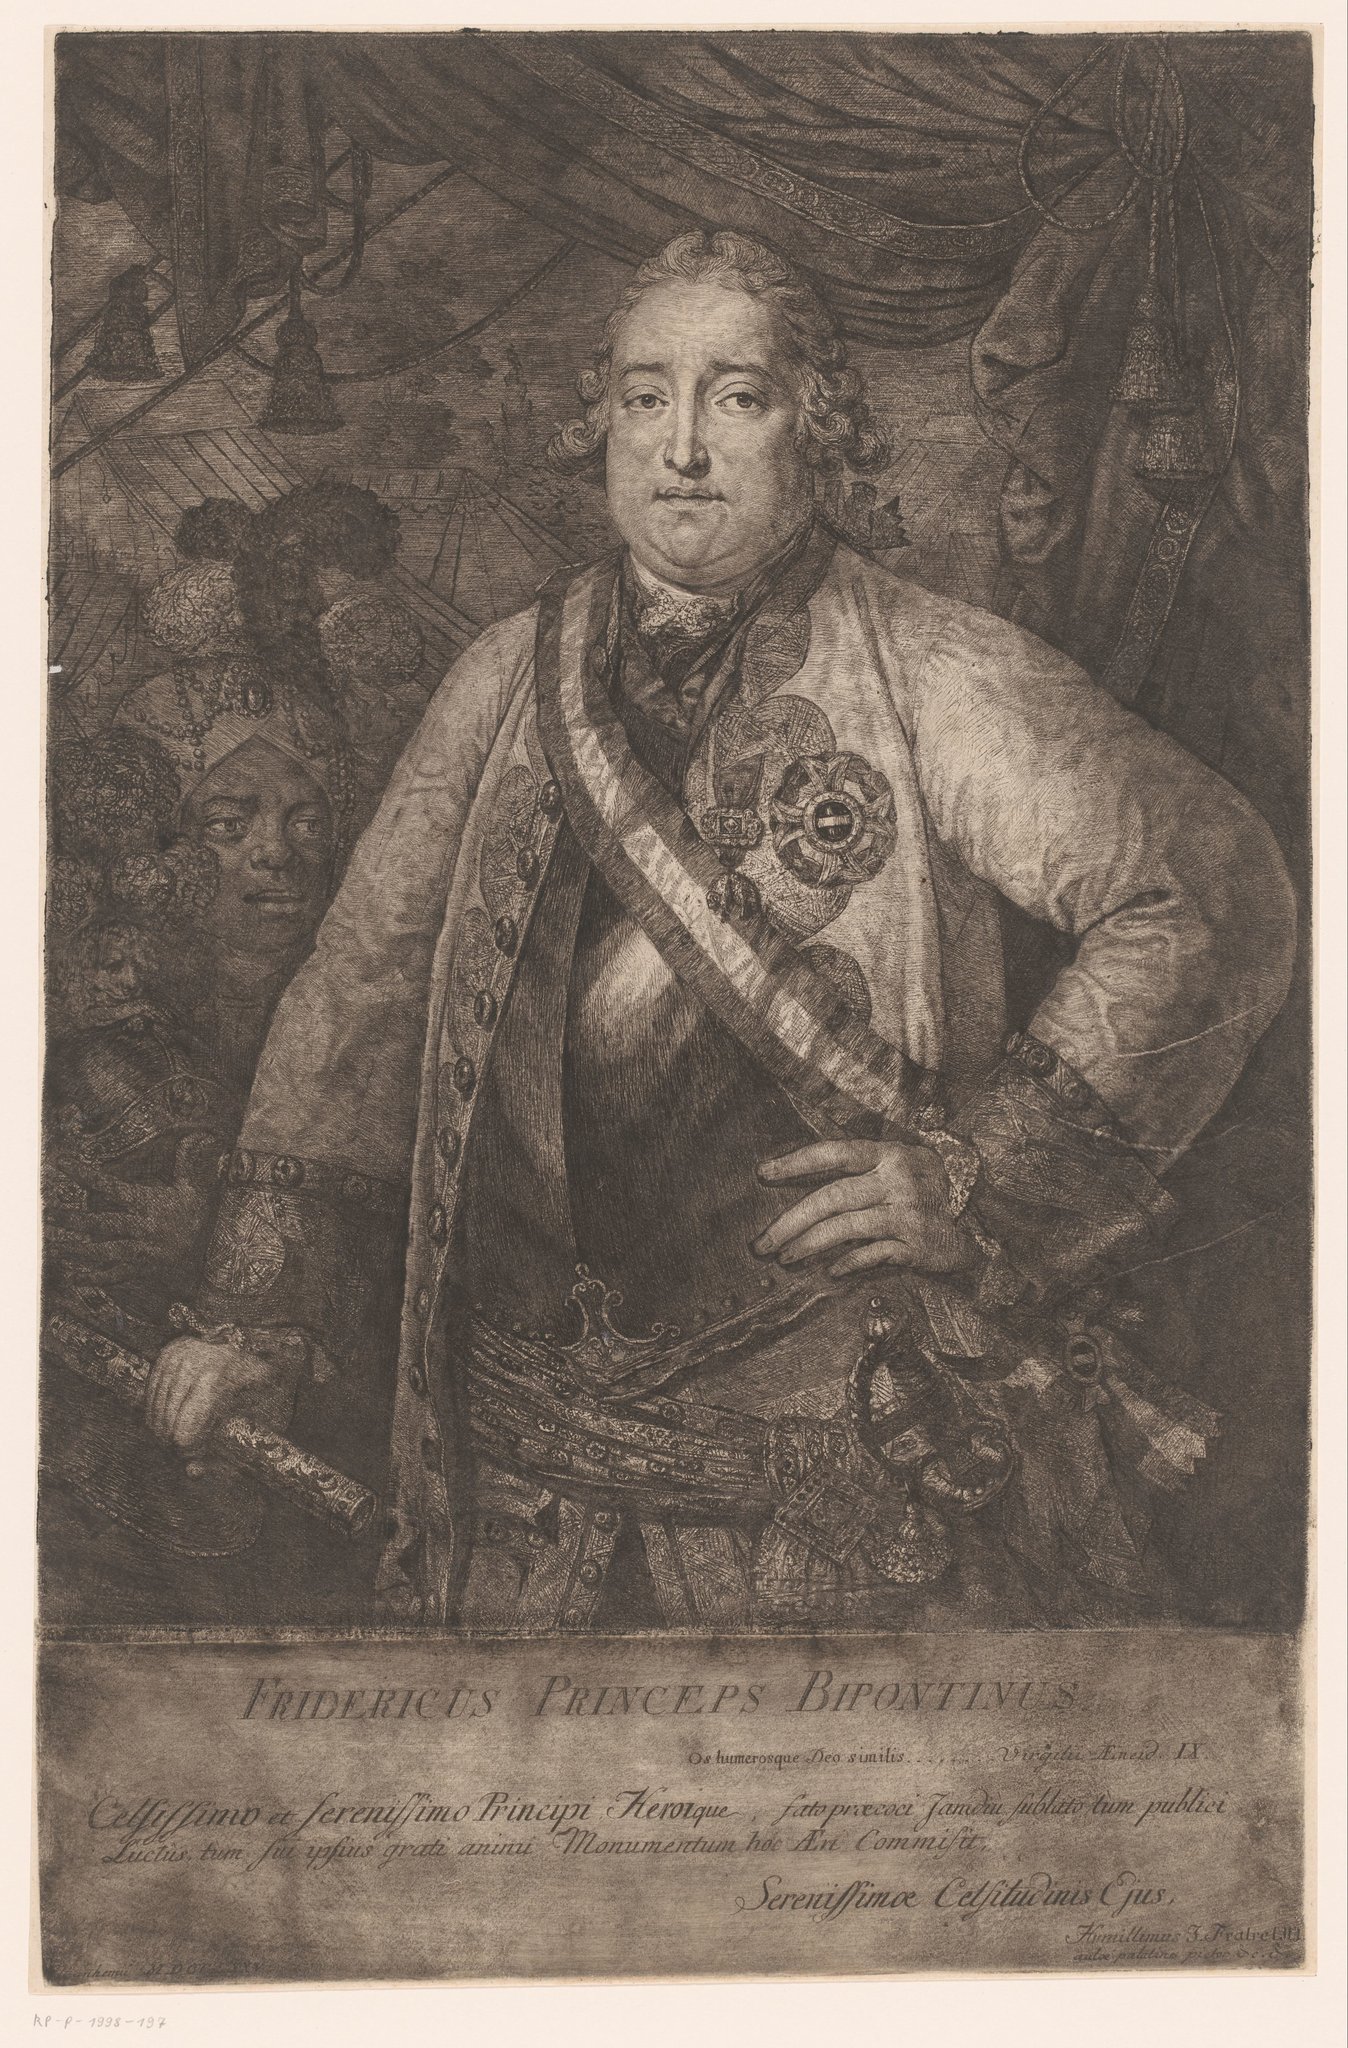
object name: print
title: Oeuvre de Joseph Fratrel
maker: joseph i fratrel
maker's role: print maker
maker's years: 1730-1783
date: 1775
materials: paper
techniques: drypoint, etching, intaglio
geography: france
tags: (feigned) picture curtain, historical persons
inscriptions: collector's mark: Lugt 2228